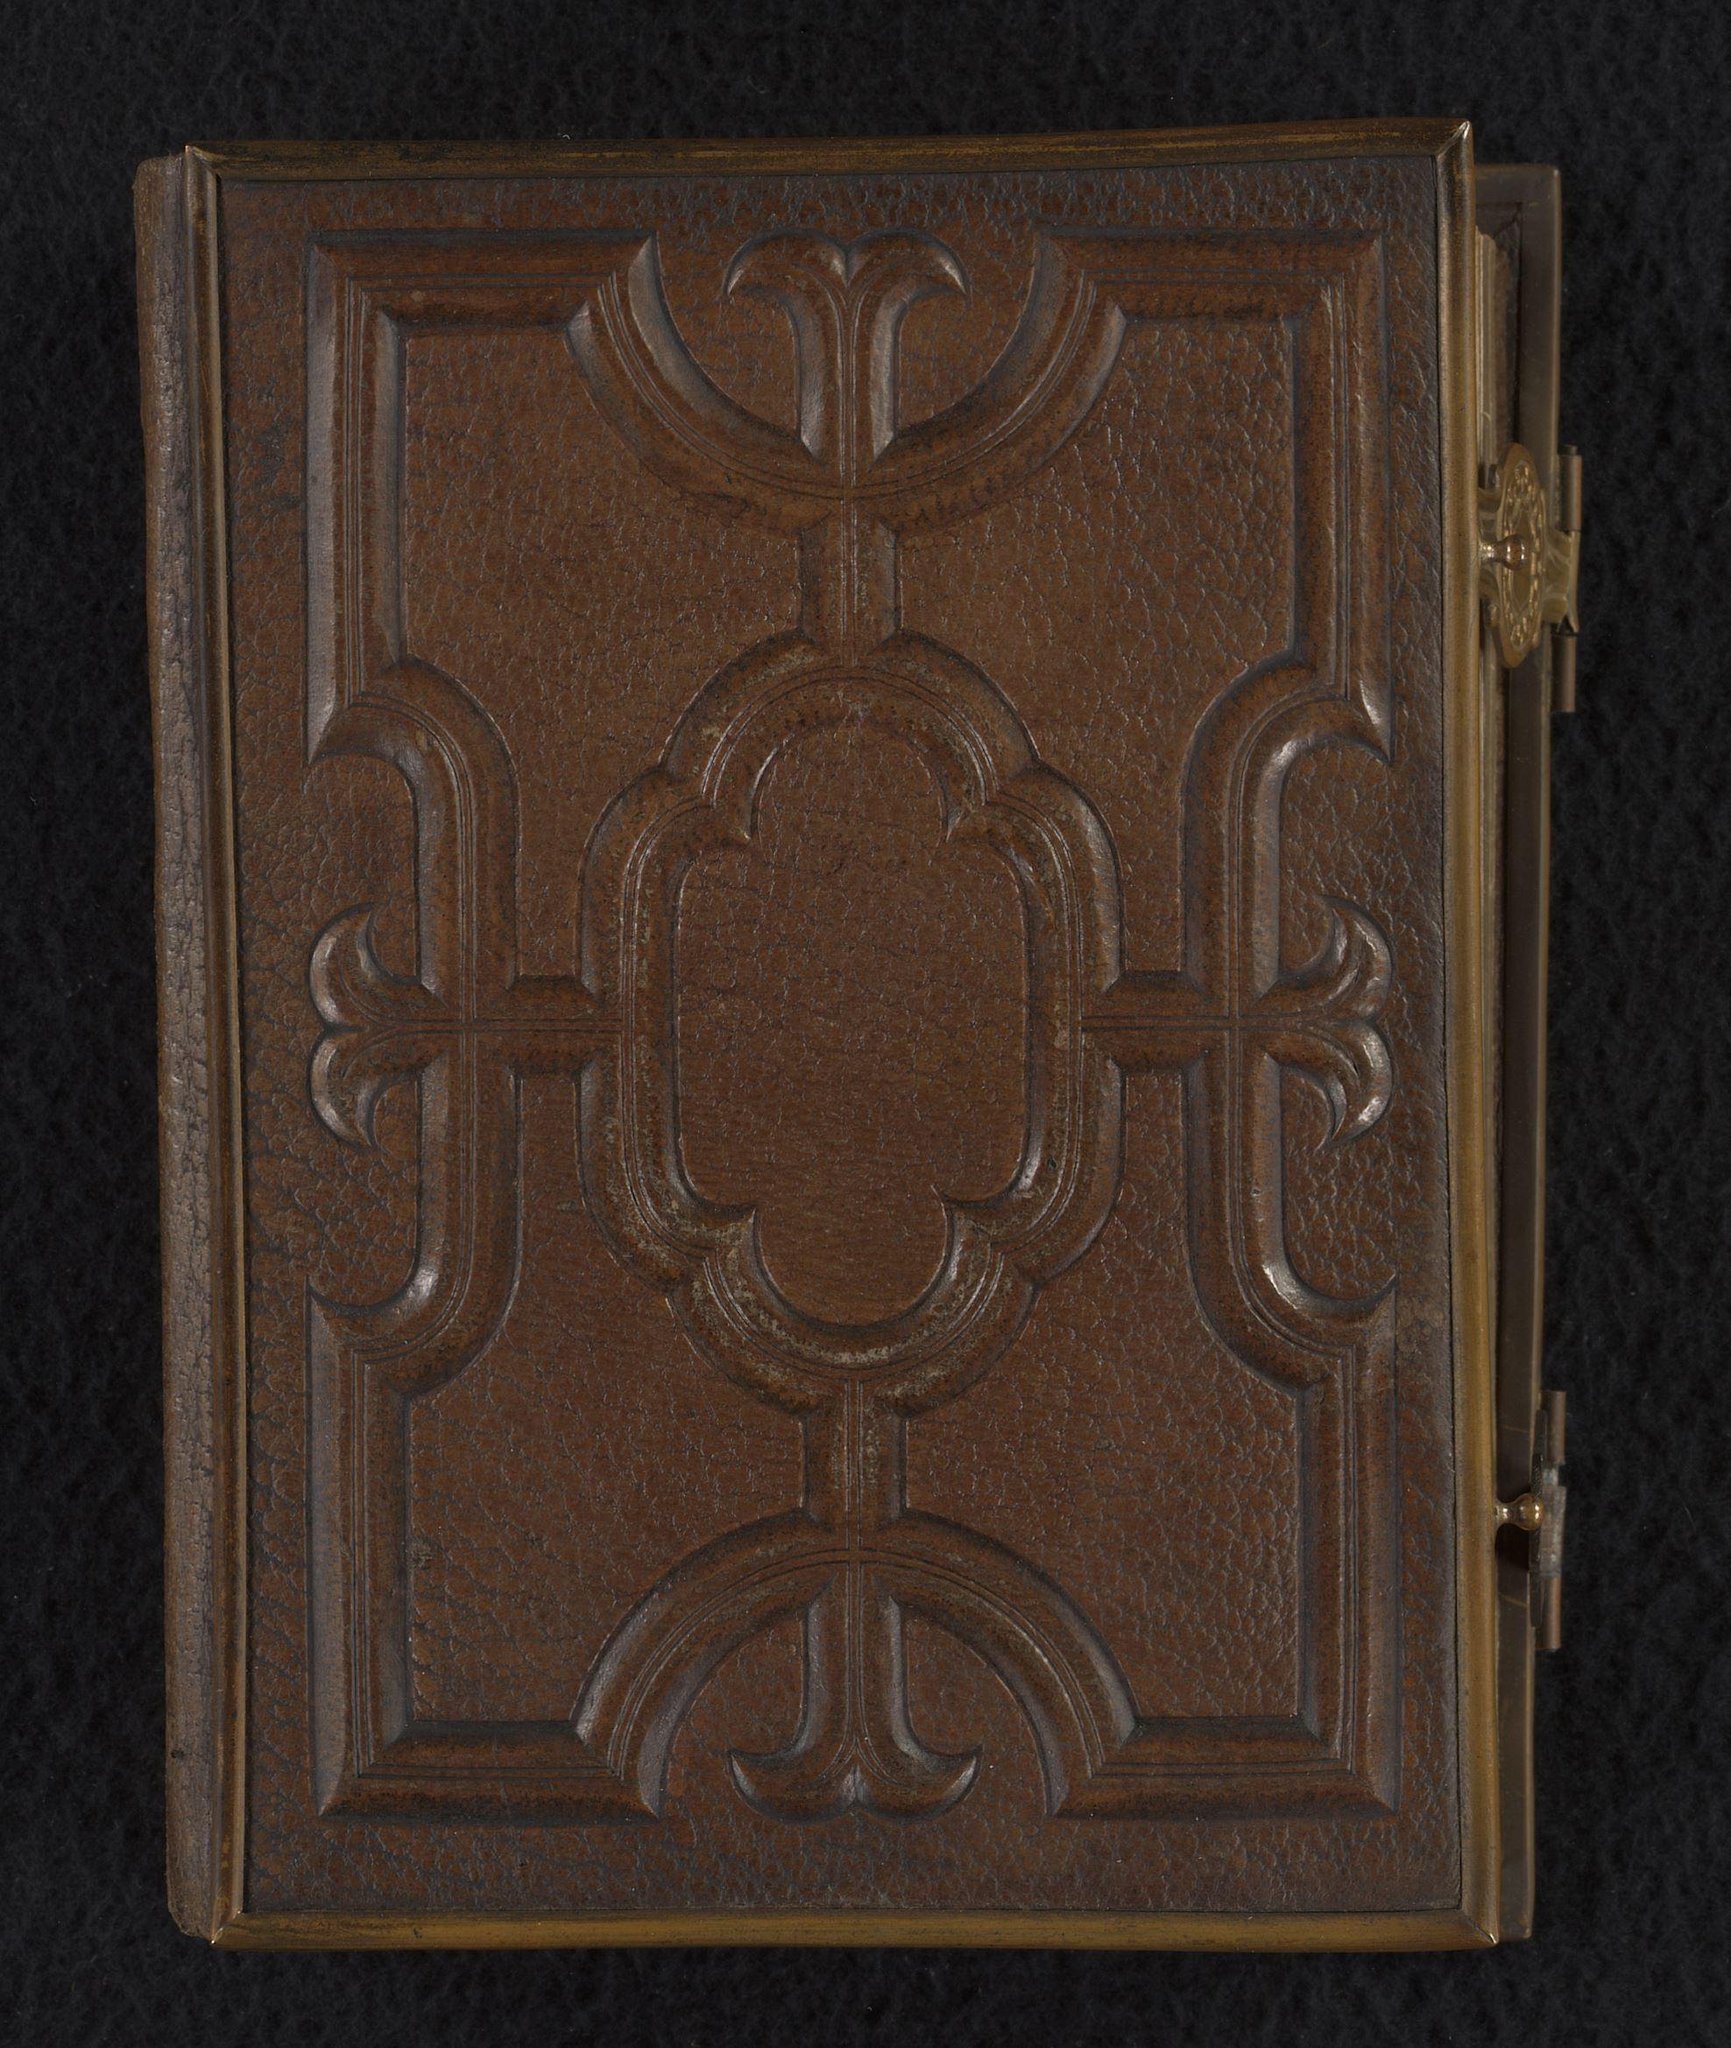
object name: photograph album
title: Fotoalbum met 46 foto's (Nederlands)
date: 1873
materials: cardboard, leather, metal, photographic support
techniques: albumen print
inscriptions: inscription: ‘Dienst Verspreide Rijkskollekties (...)’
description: Album met 46 foto's, voornamelijk portretten op cartes-de-visite.